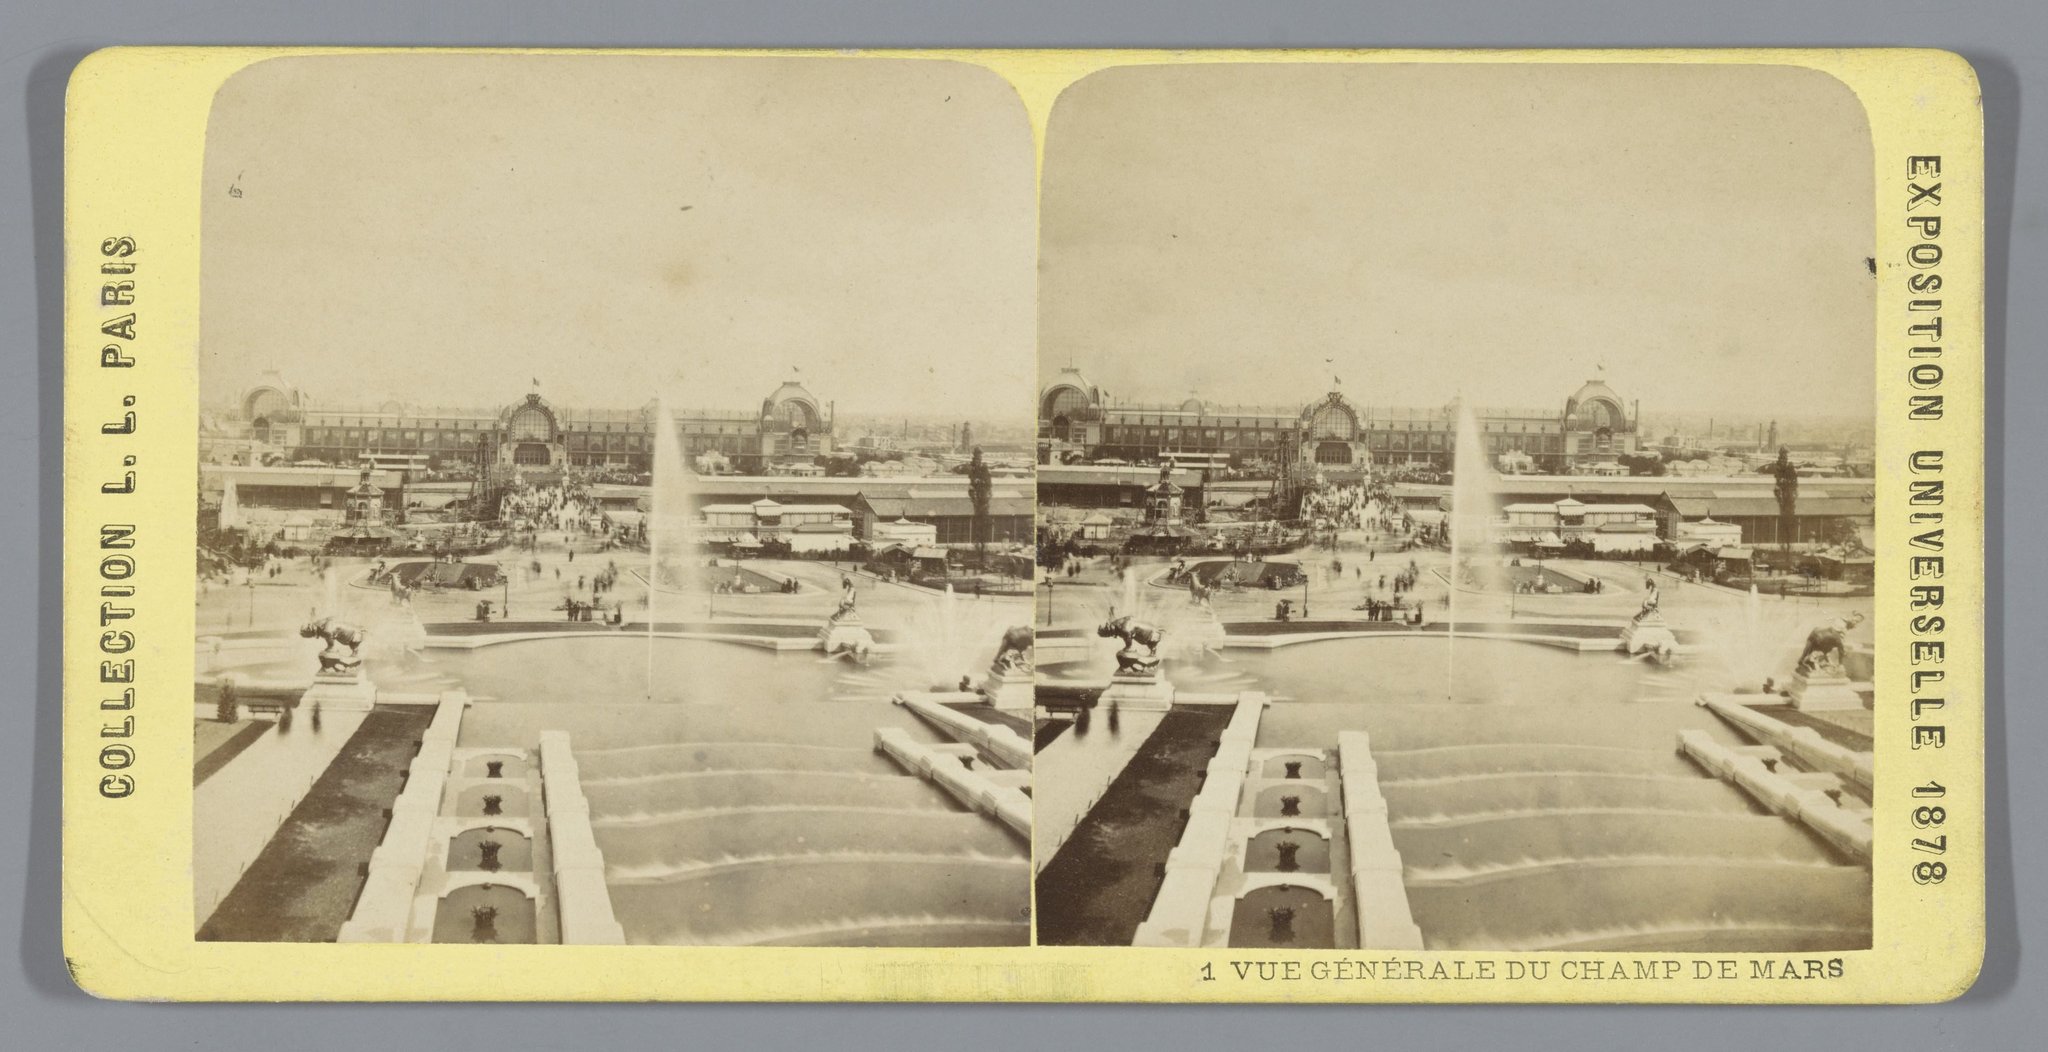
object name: stereograph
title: Exposition universelle 1878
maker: Anonymous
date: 1878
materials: cardboard, paper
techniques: albumen print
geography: paris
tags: world fair, world exhibition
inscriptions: number: ‘1’